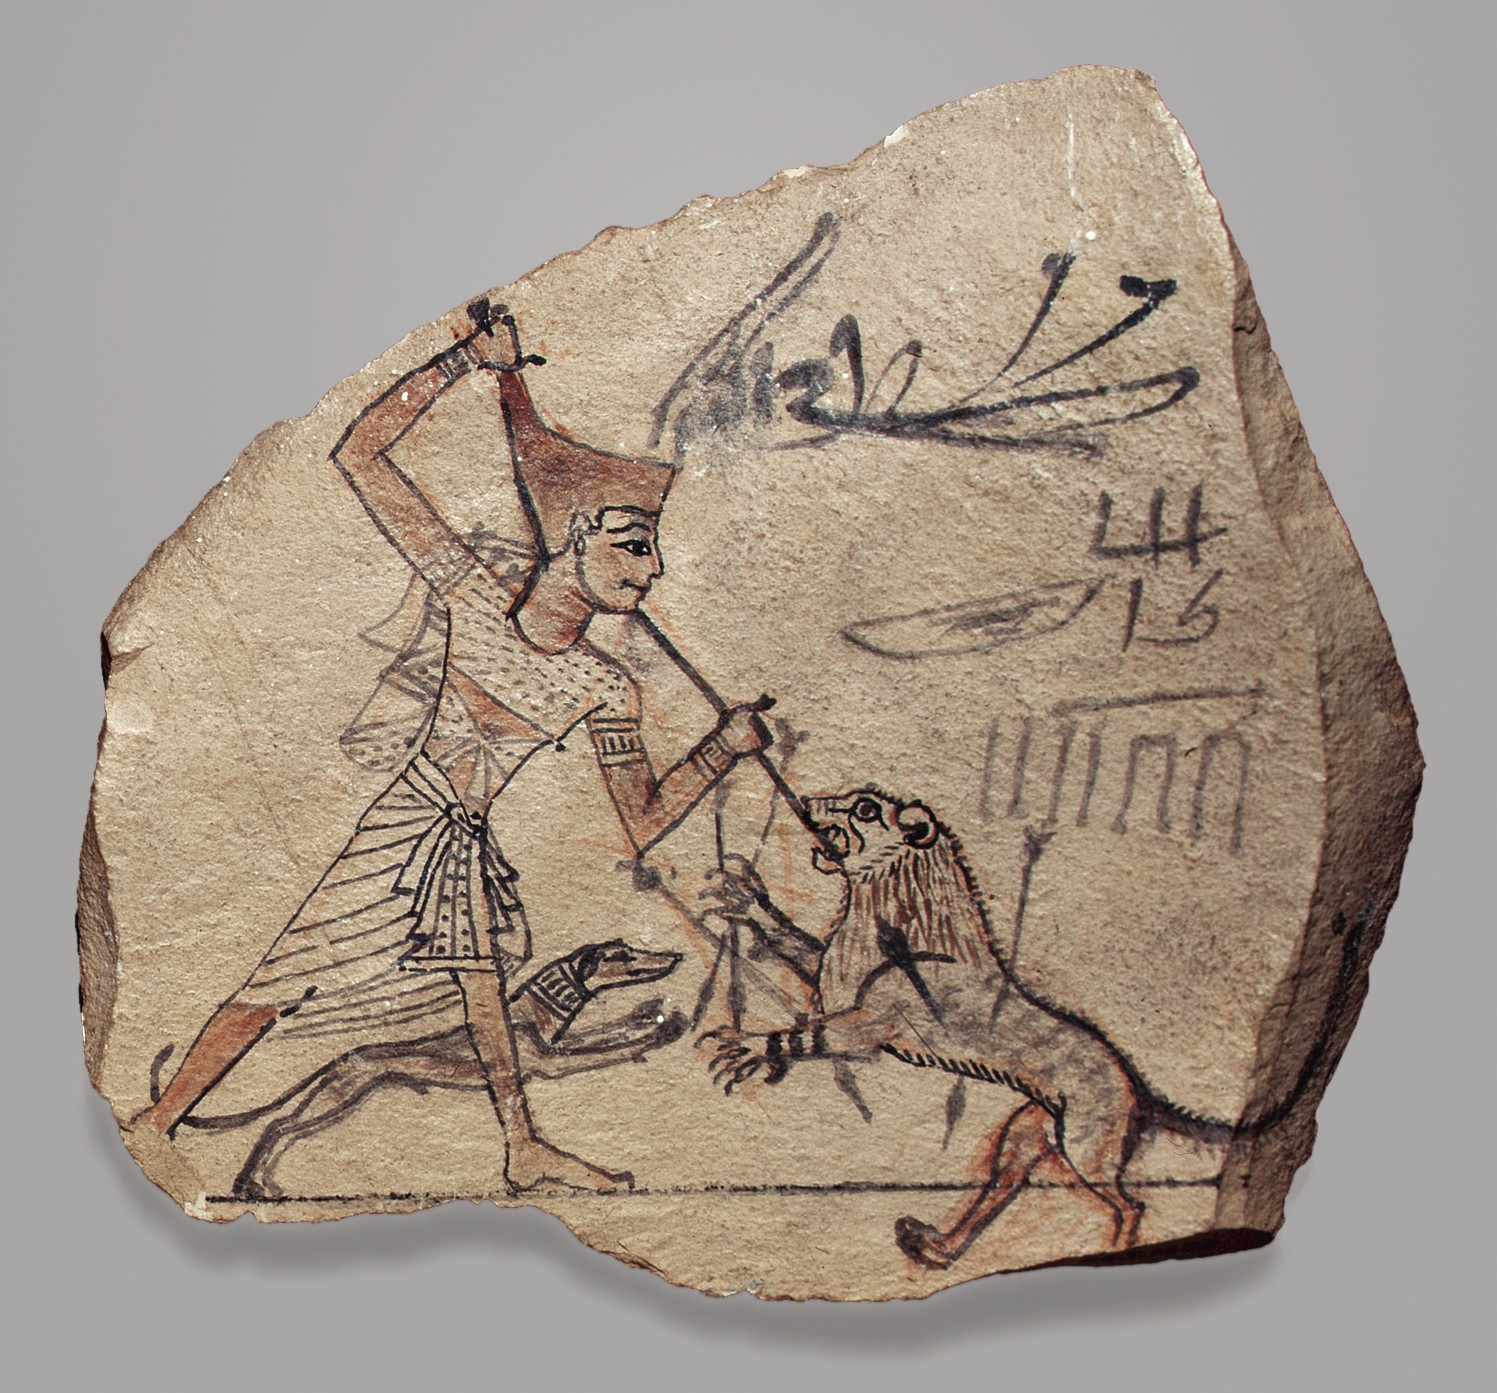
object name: ostracon, figured, pharaoh, lion, hieratic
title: Ostracon with Pharaoh Spearing a Lion and a Royal Hymn on its Back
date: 1186-1070 BCE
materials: ink, limestone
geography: egypt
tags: men,hunting,dogs,lions